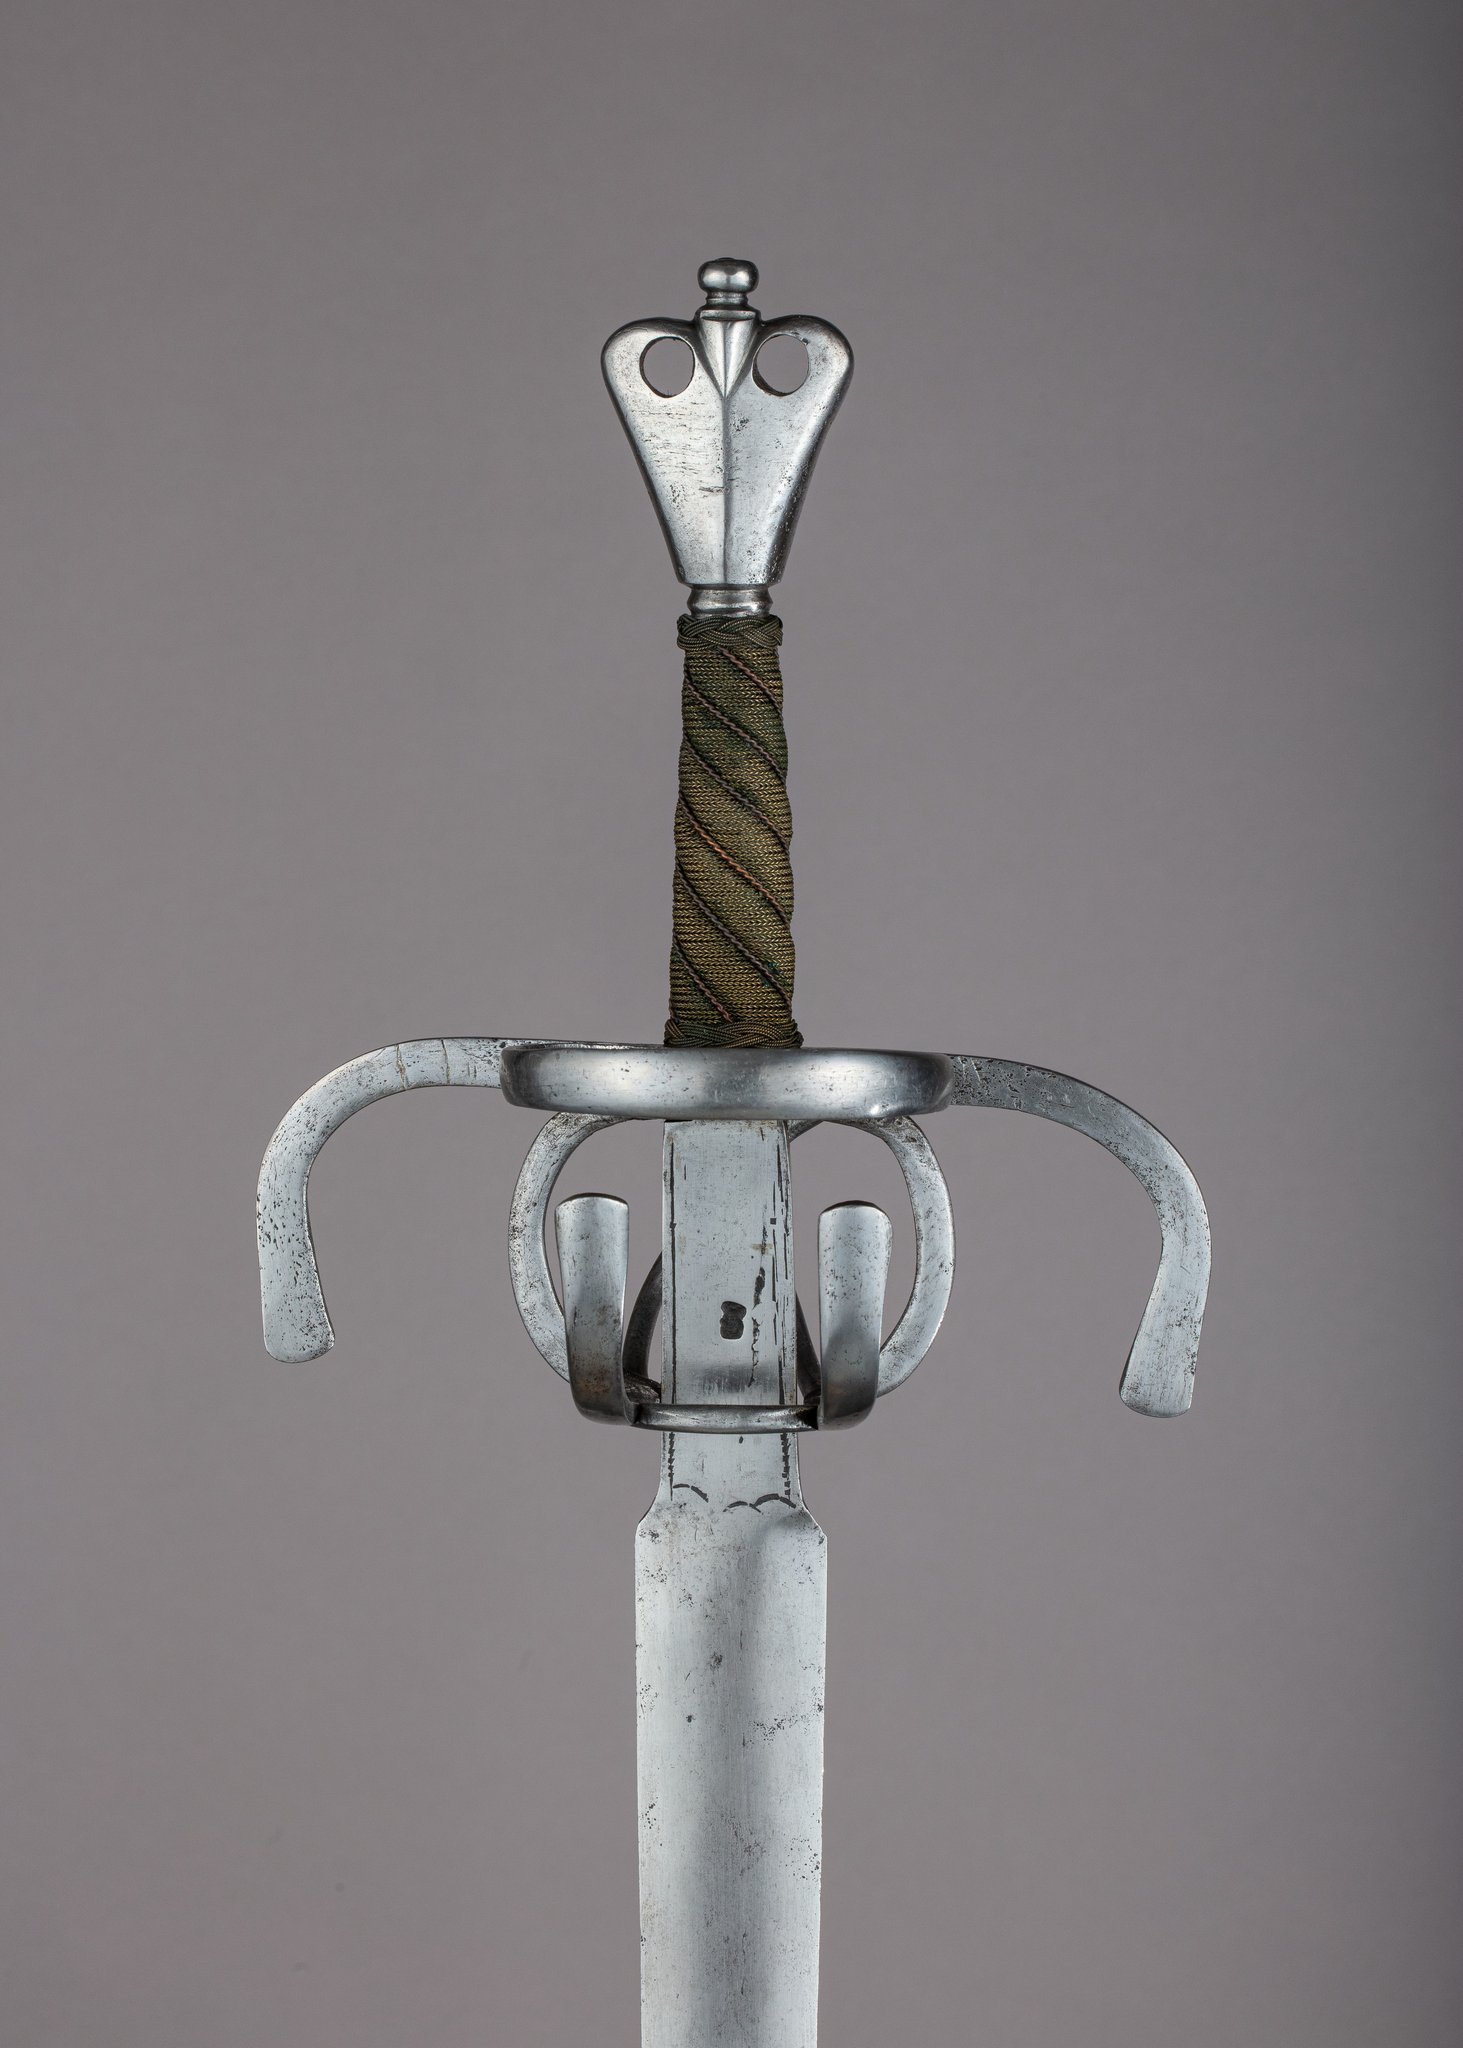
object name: rapier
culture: italian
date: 1501-1600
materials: copper, steel, metal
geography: italy